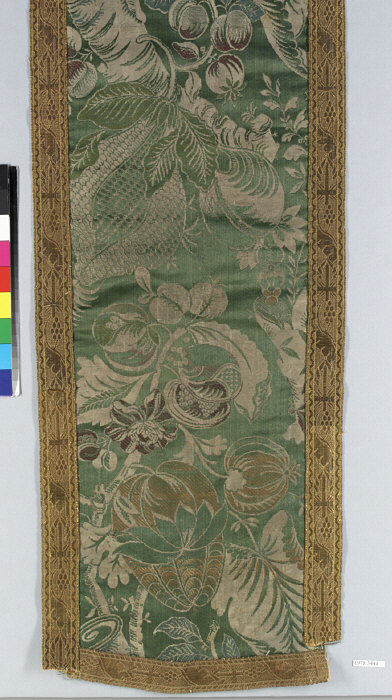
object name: orphrey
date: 1742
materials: metal thread, silk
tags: flowers